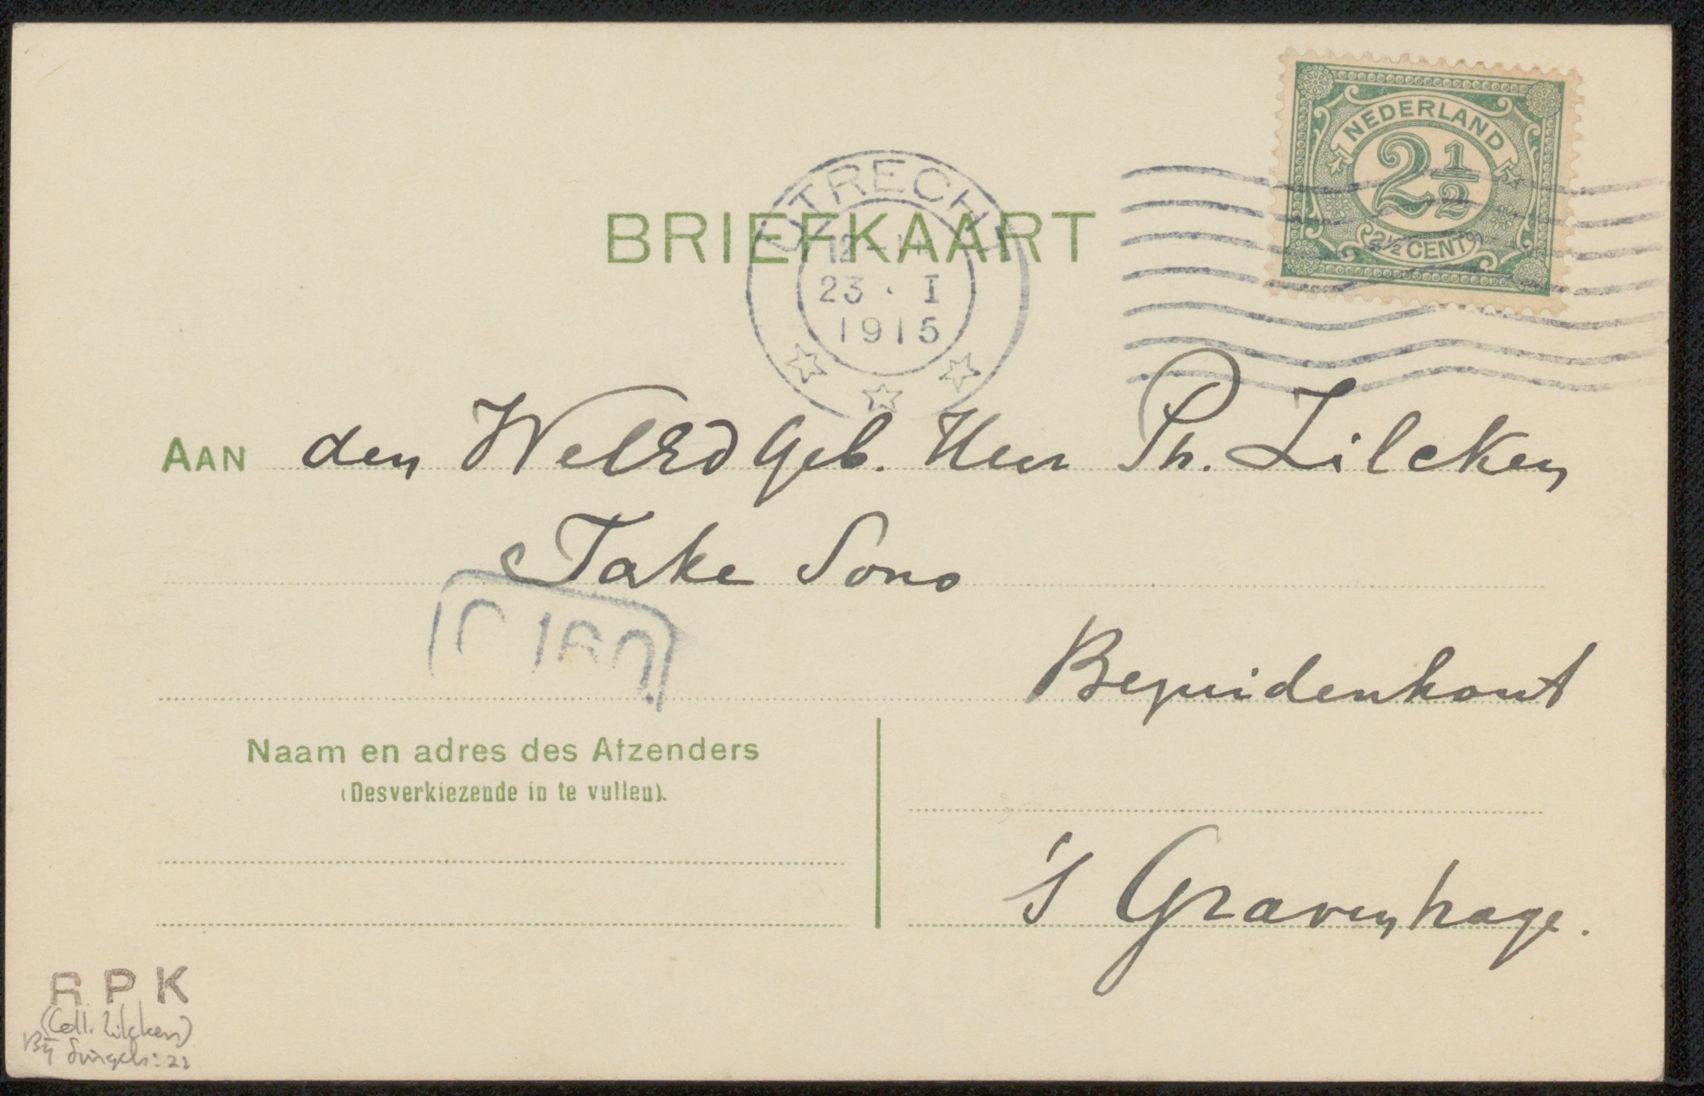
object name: postcard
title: Briefkaart aan Philip Zilcken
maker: n.j. singels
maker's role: leraar, schrijver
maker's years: 1857-1931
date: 1915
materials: cardboard, ink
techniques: pen, writing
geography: utrecht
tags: print maker, elisabeth adriani-hovy, painter, draughtsman, philip zilcken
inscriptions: collector's mark: ‘RPK’